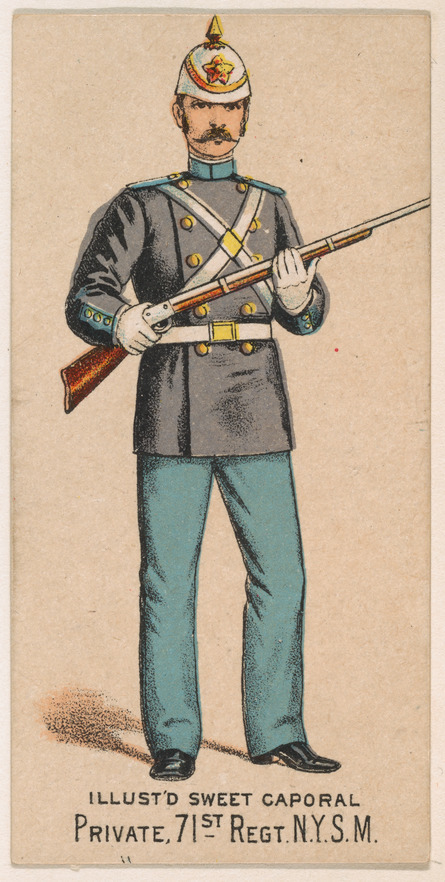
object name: print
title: Private, 71st Regiment, New York State Militia, from the Military Series (N224) issued by Kinney Tobacco Company to promote Sweet Caporal Cigarettes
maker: kinney brothers tobacco company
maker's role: publisher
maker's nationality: american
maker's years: 1869-2011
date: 1888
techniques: color lithograph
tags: military,firearms,men